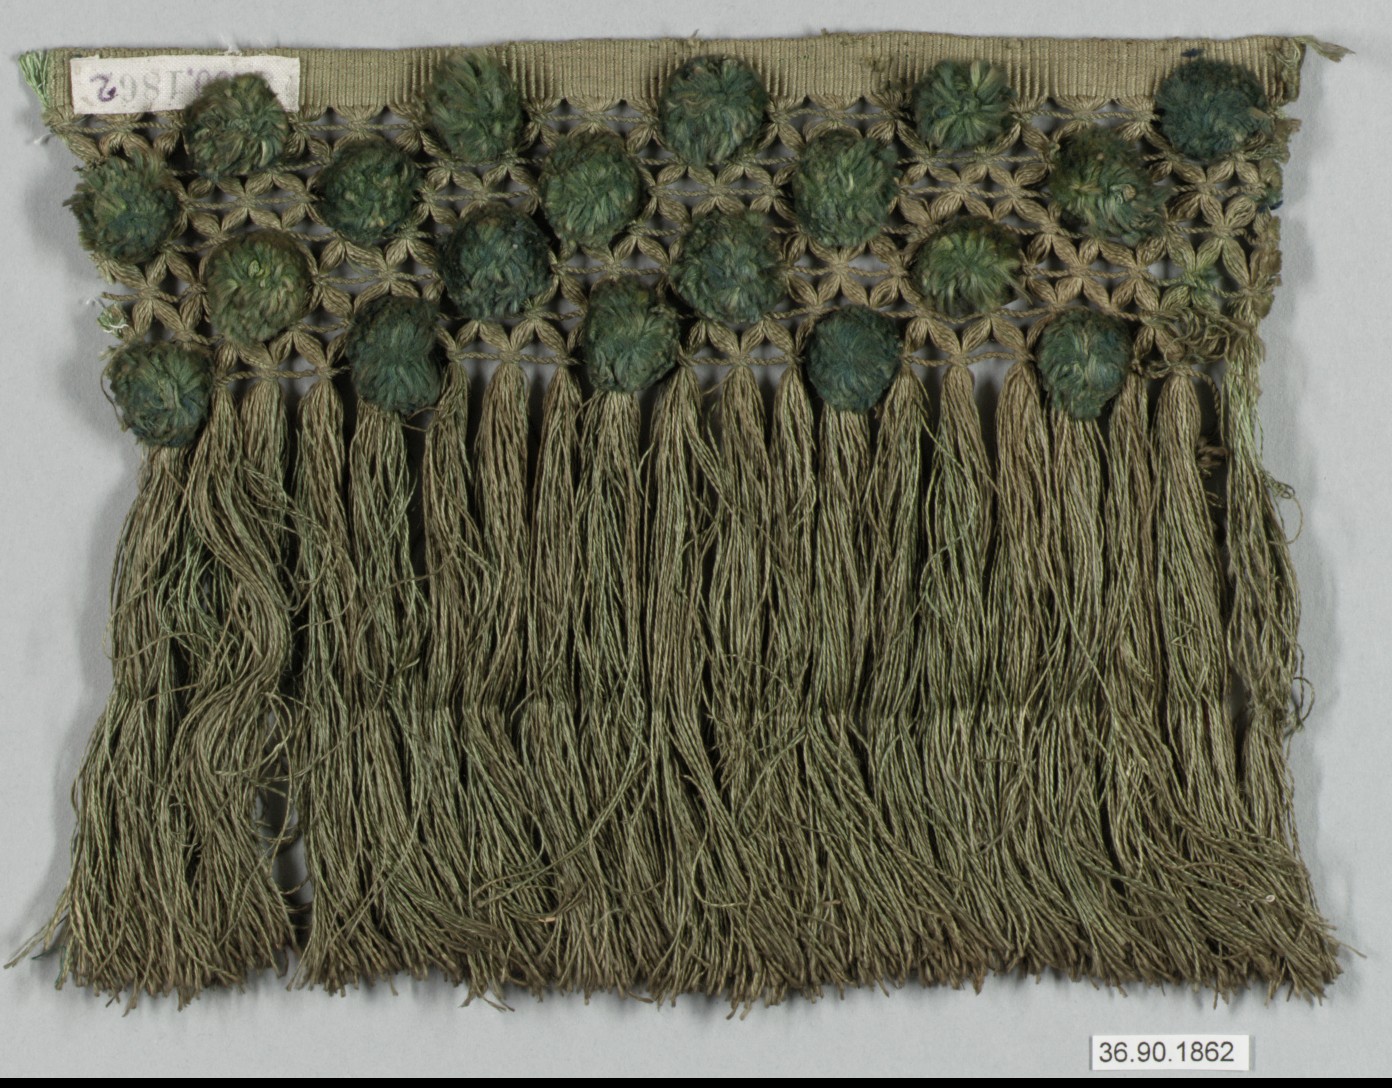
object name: fringe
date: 1701-1800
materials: silk